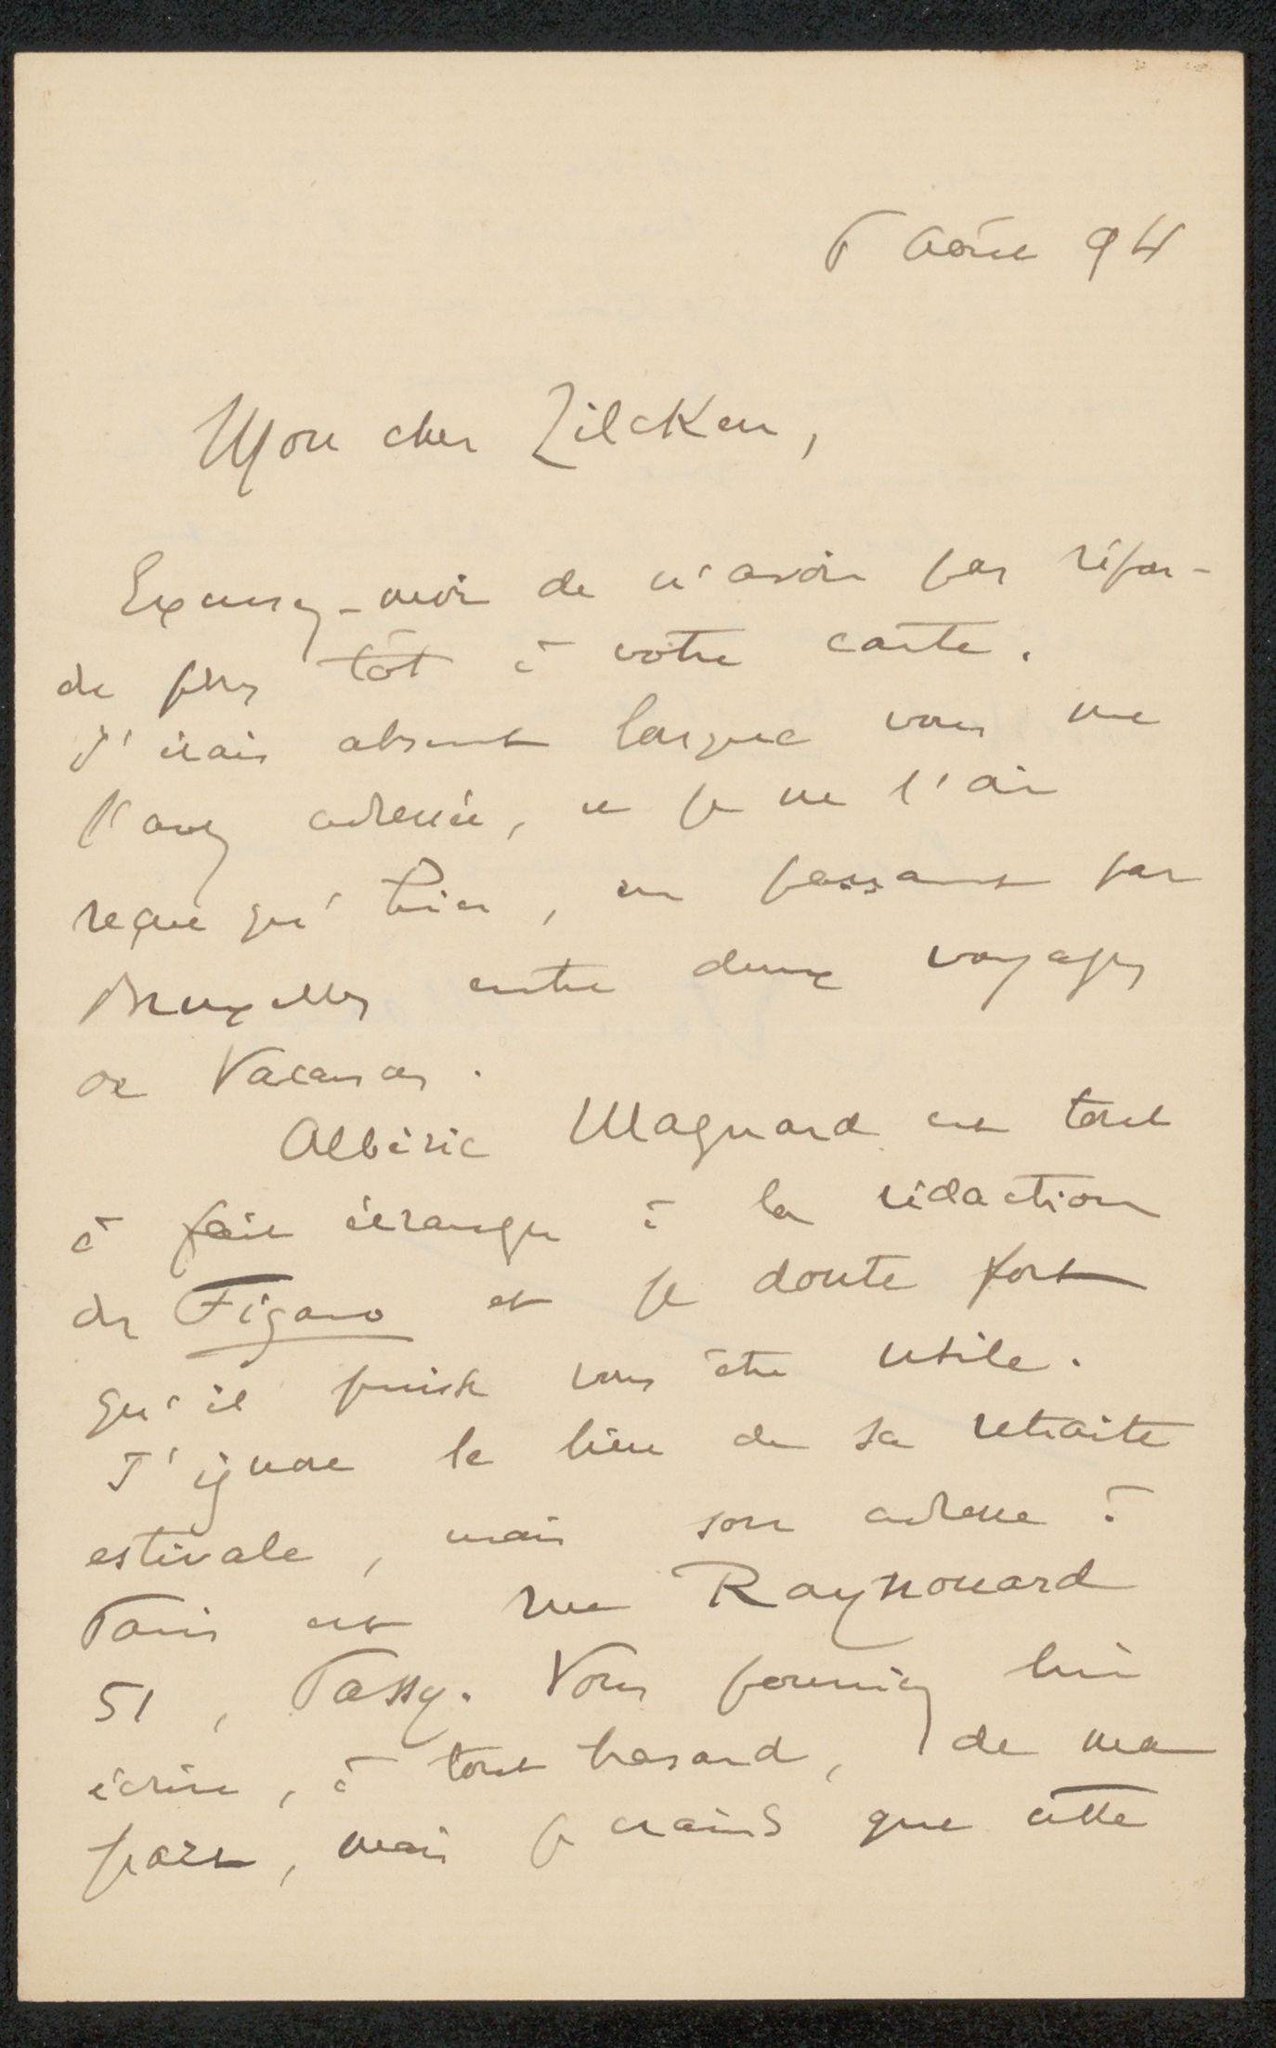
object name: letter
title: Brief aan Philip Zilcken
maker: octave maus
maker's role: painter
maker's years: 1856-1919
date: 1894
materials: ink, paper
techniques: pen, printing, writing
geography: brussels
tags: paris, hector berlioz, the hague, painter, draughtsman, philip zilcken, travelling; tourism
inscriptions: collector's mark: ‘RPK’, watermark